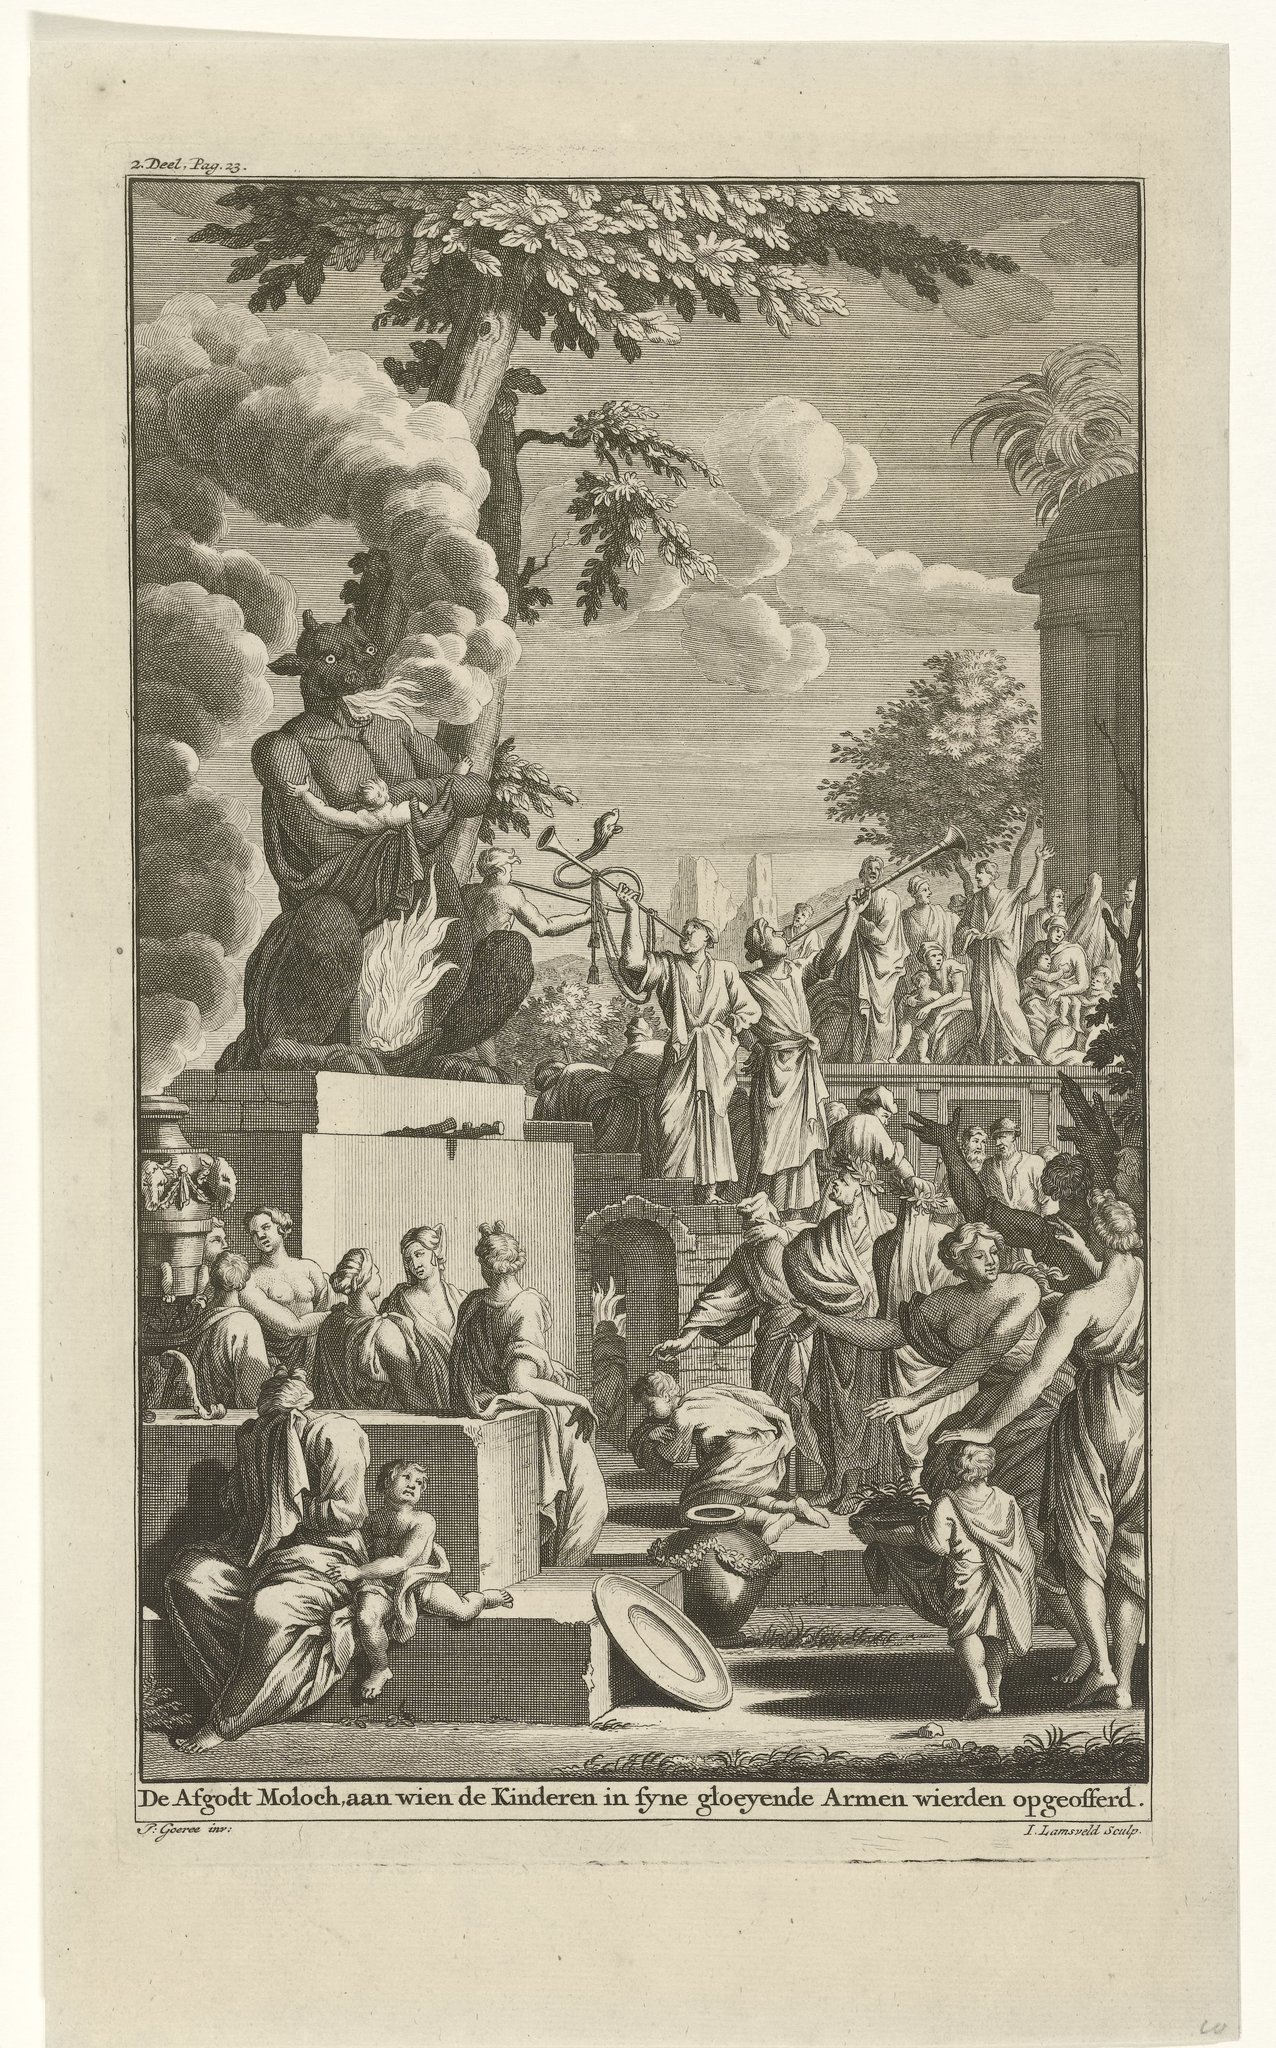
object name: book illustration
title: Afgod Moloch ontvangt mensenoffers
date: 1684-1743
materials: paper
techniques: engraving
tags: the israelites worship baal, ashtaroth, and other idols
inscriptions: collector's mark: Lugt 2228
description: Bijbelse voorstelling uit het Oude Testament. De afgod Moloch heeft een kind in zijn armen dat door de Israëlieten aan hem is geofferd. Rond het beeld van Moloch kijkt een menigte mensen toe, naast het beeld blazen drie figuren de bazuin. Prent rechtsboven gemerkt: 2. Deel, Pag. 23.